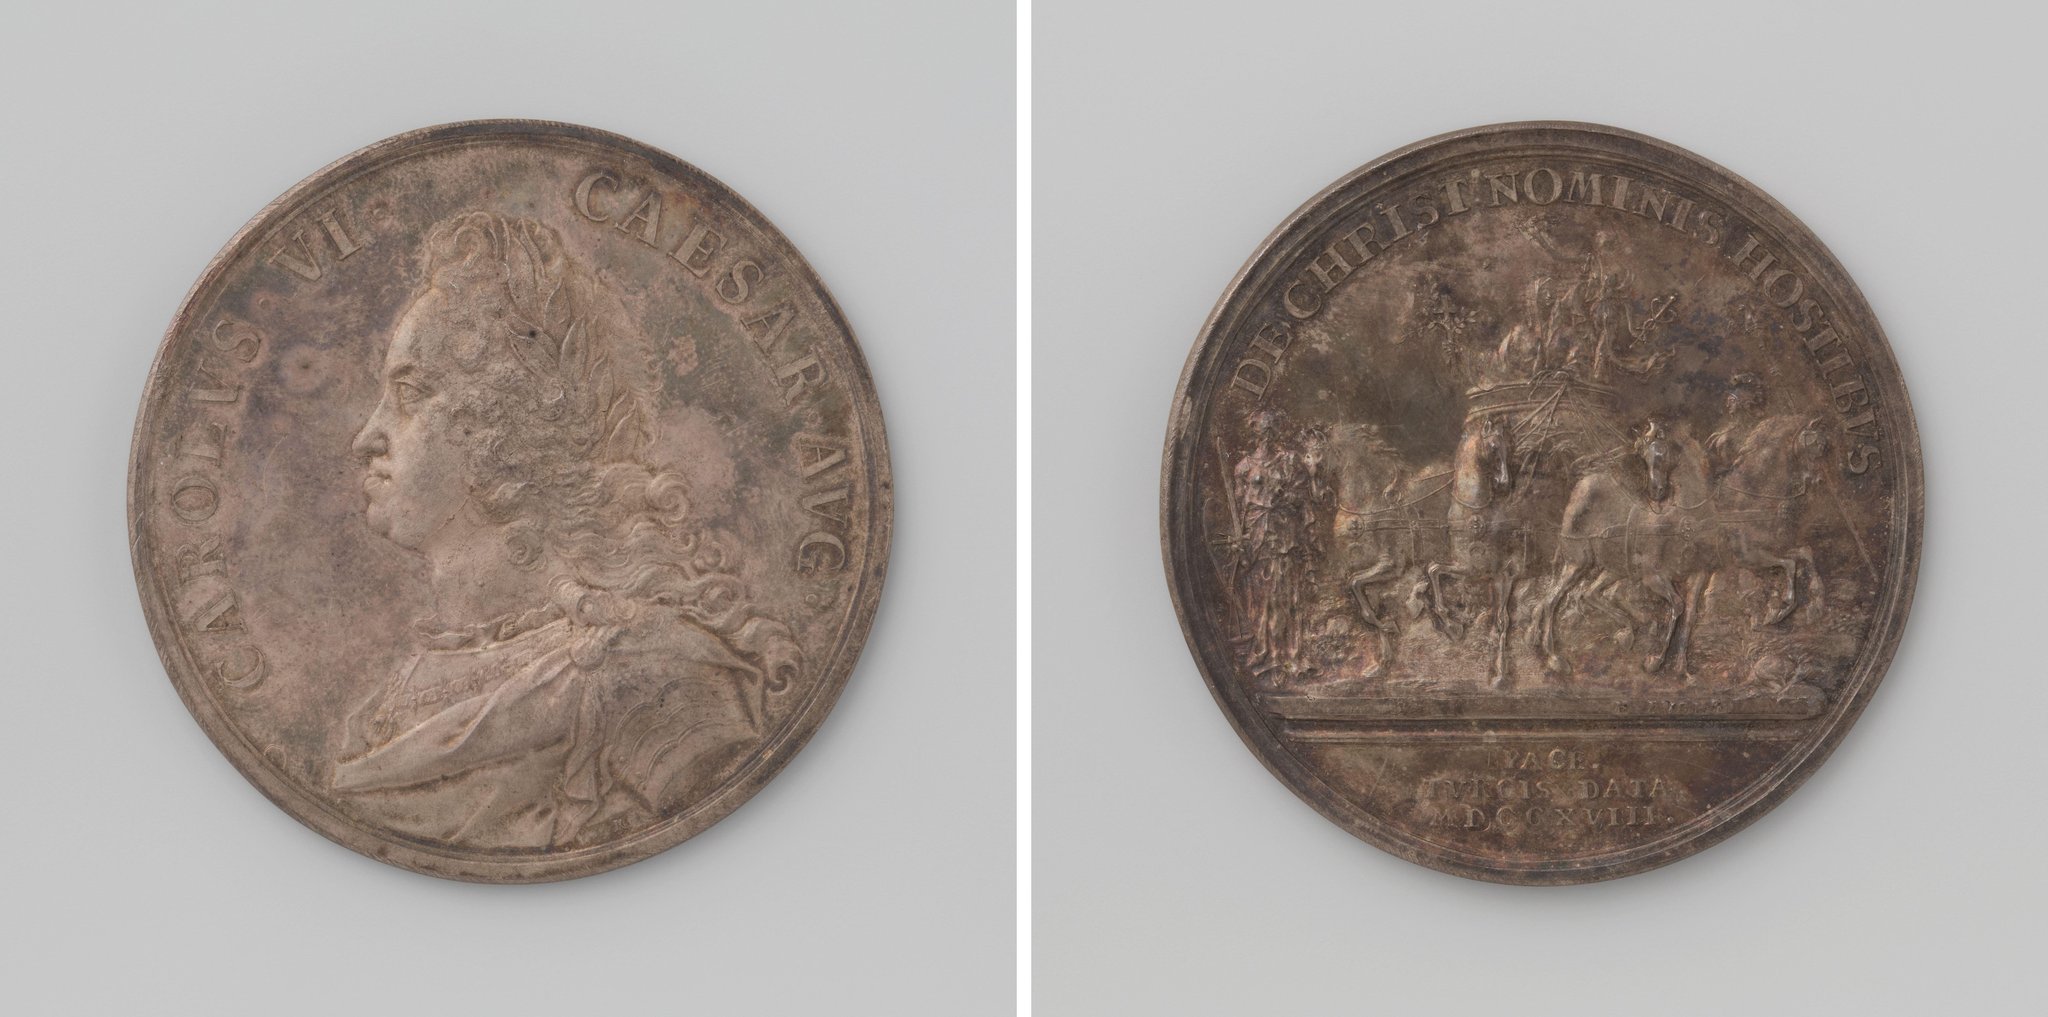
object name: history medal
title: Vrede te Passarowitz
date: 1718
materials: silver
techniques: striking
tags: vienna, charles vi (holy roman emperor)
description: Zilveren penning. Voorzijde: borststuk man met lauwerkrans binnen omschrift. Keerzijde: man in toga met sluier over hoofd en kruis met olijftak in hand ment vierspan, geleid door vrouw met zwaard en schild in hand en gehelmde vrouw met standaard, Overwinning staande op vierspan houdt lauwerkrans boven hoofd van man in toga en Mercuriusstaf in andere hand binnen omschrift; afsnede: opschrift.